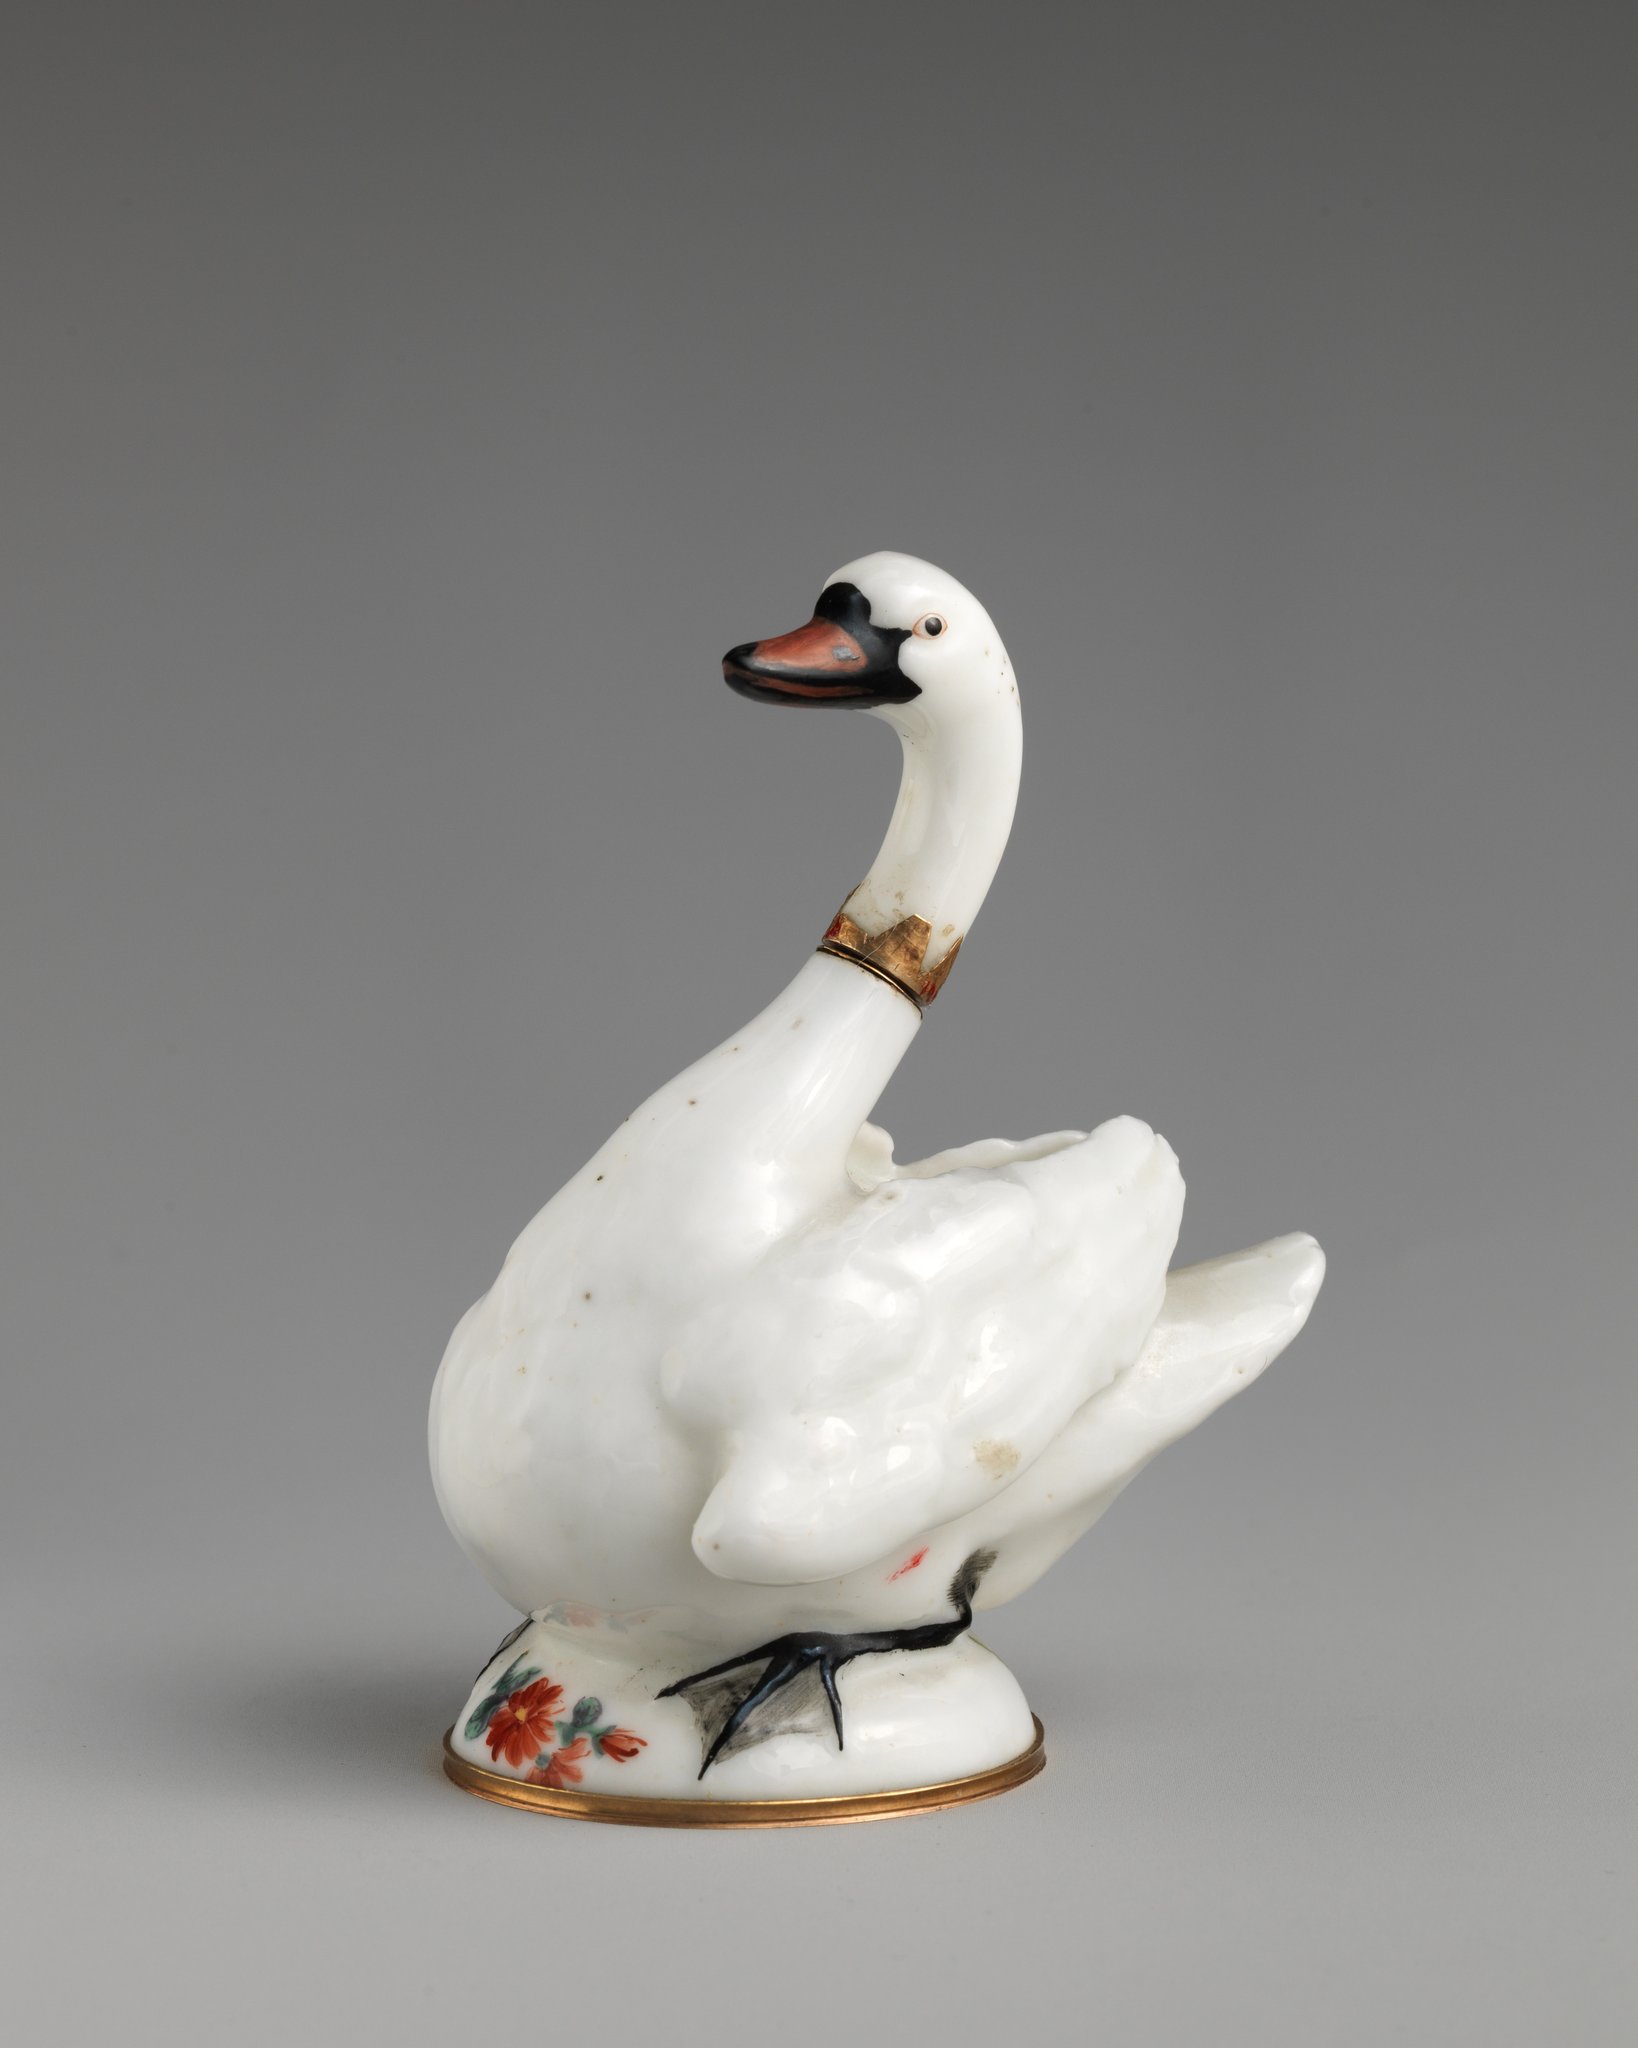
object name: scent bottle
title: Scent bottle in the form of a swan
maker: chelsea porcelain manufactory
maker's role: factory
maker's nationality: british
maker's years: 1744-1784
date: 1755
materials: soft paste porcelain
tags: swans